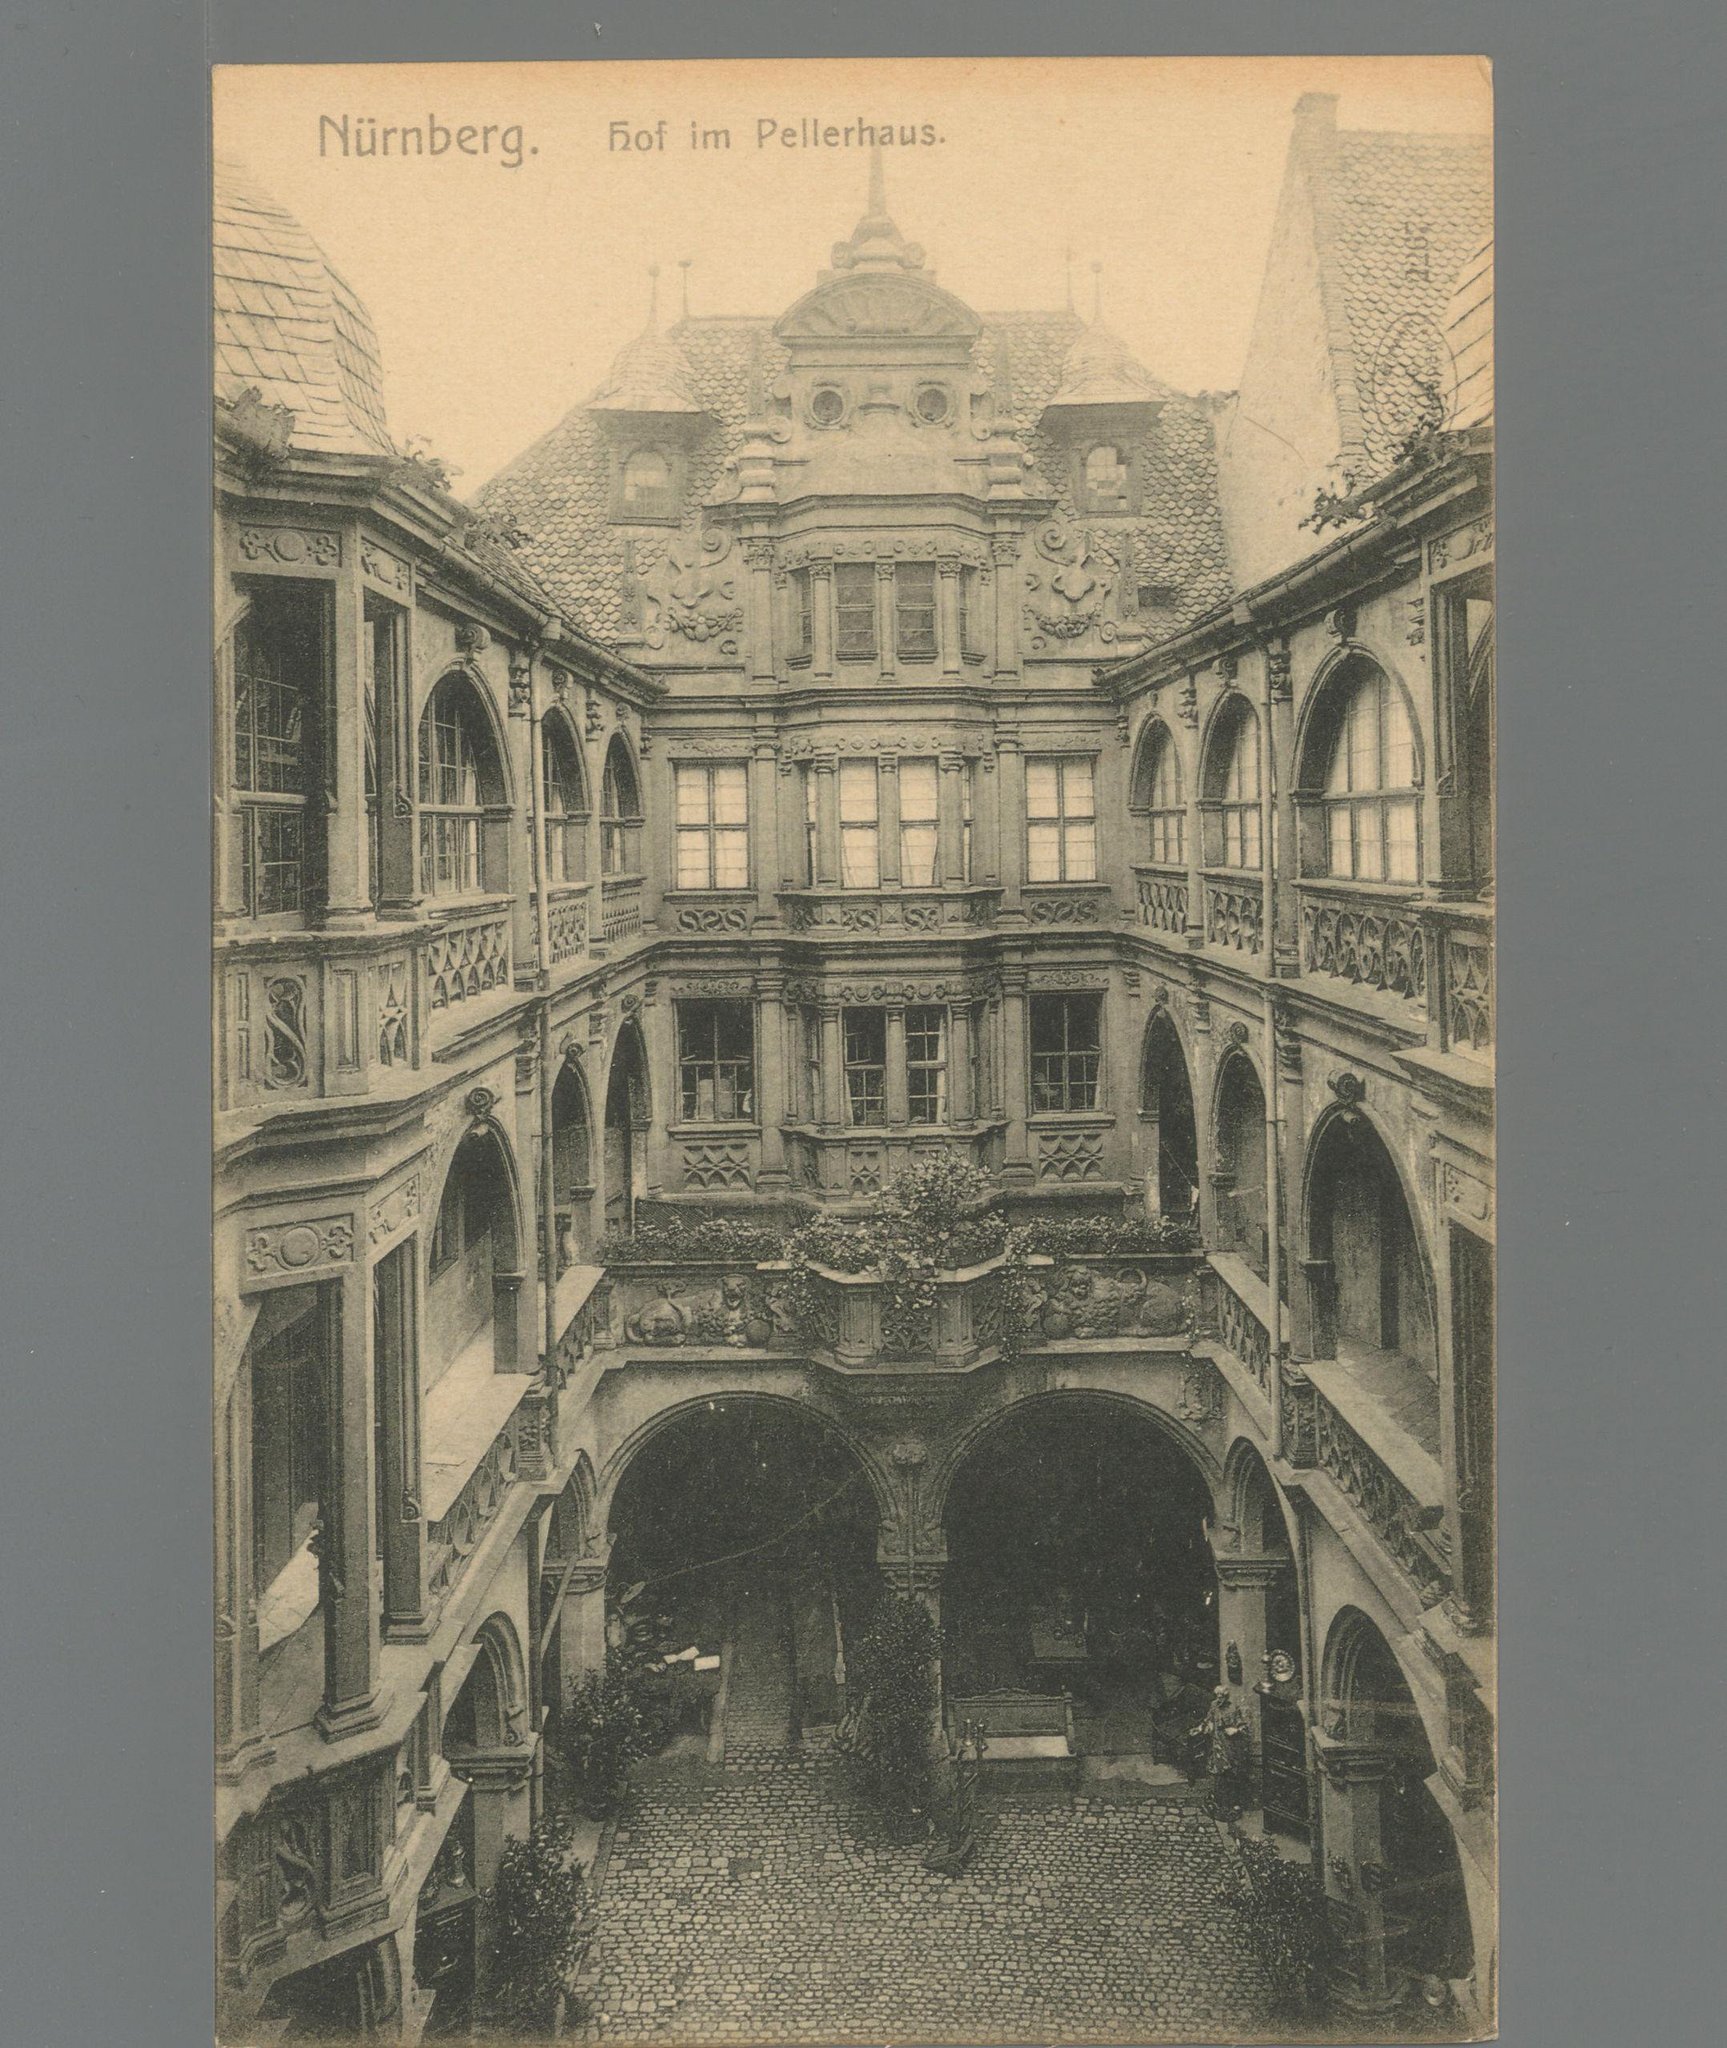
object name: photomechanical print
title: Nürnberg. Hof im Pellerhaus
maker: Anonymous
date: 1905-1930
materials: cardboard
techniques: photograph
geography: nuremberg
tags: archive, public library